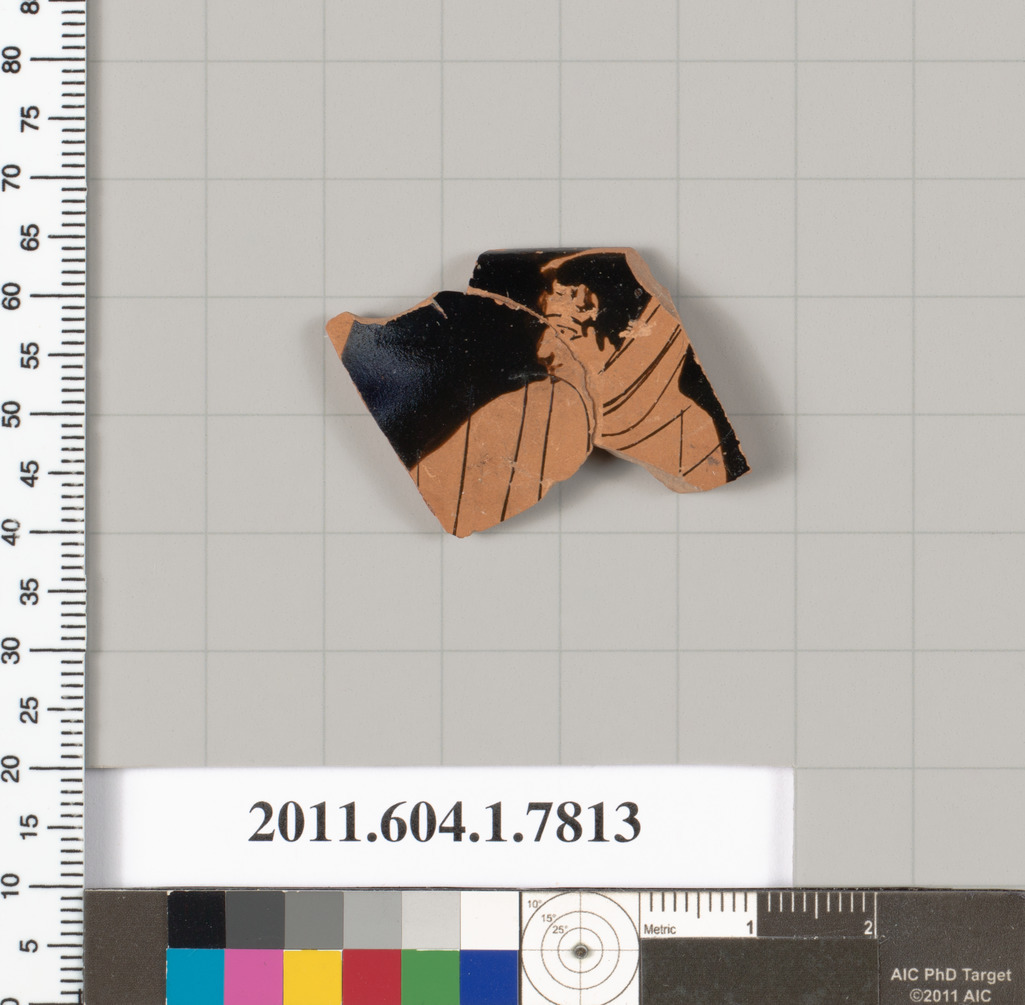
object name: kylix fragment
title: Terracotta rim fragment of a kylix (drinking cup)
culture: greek, attic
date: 460-450 BCE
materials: terracotta